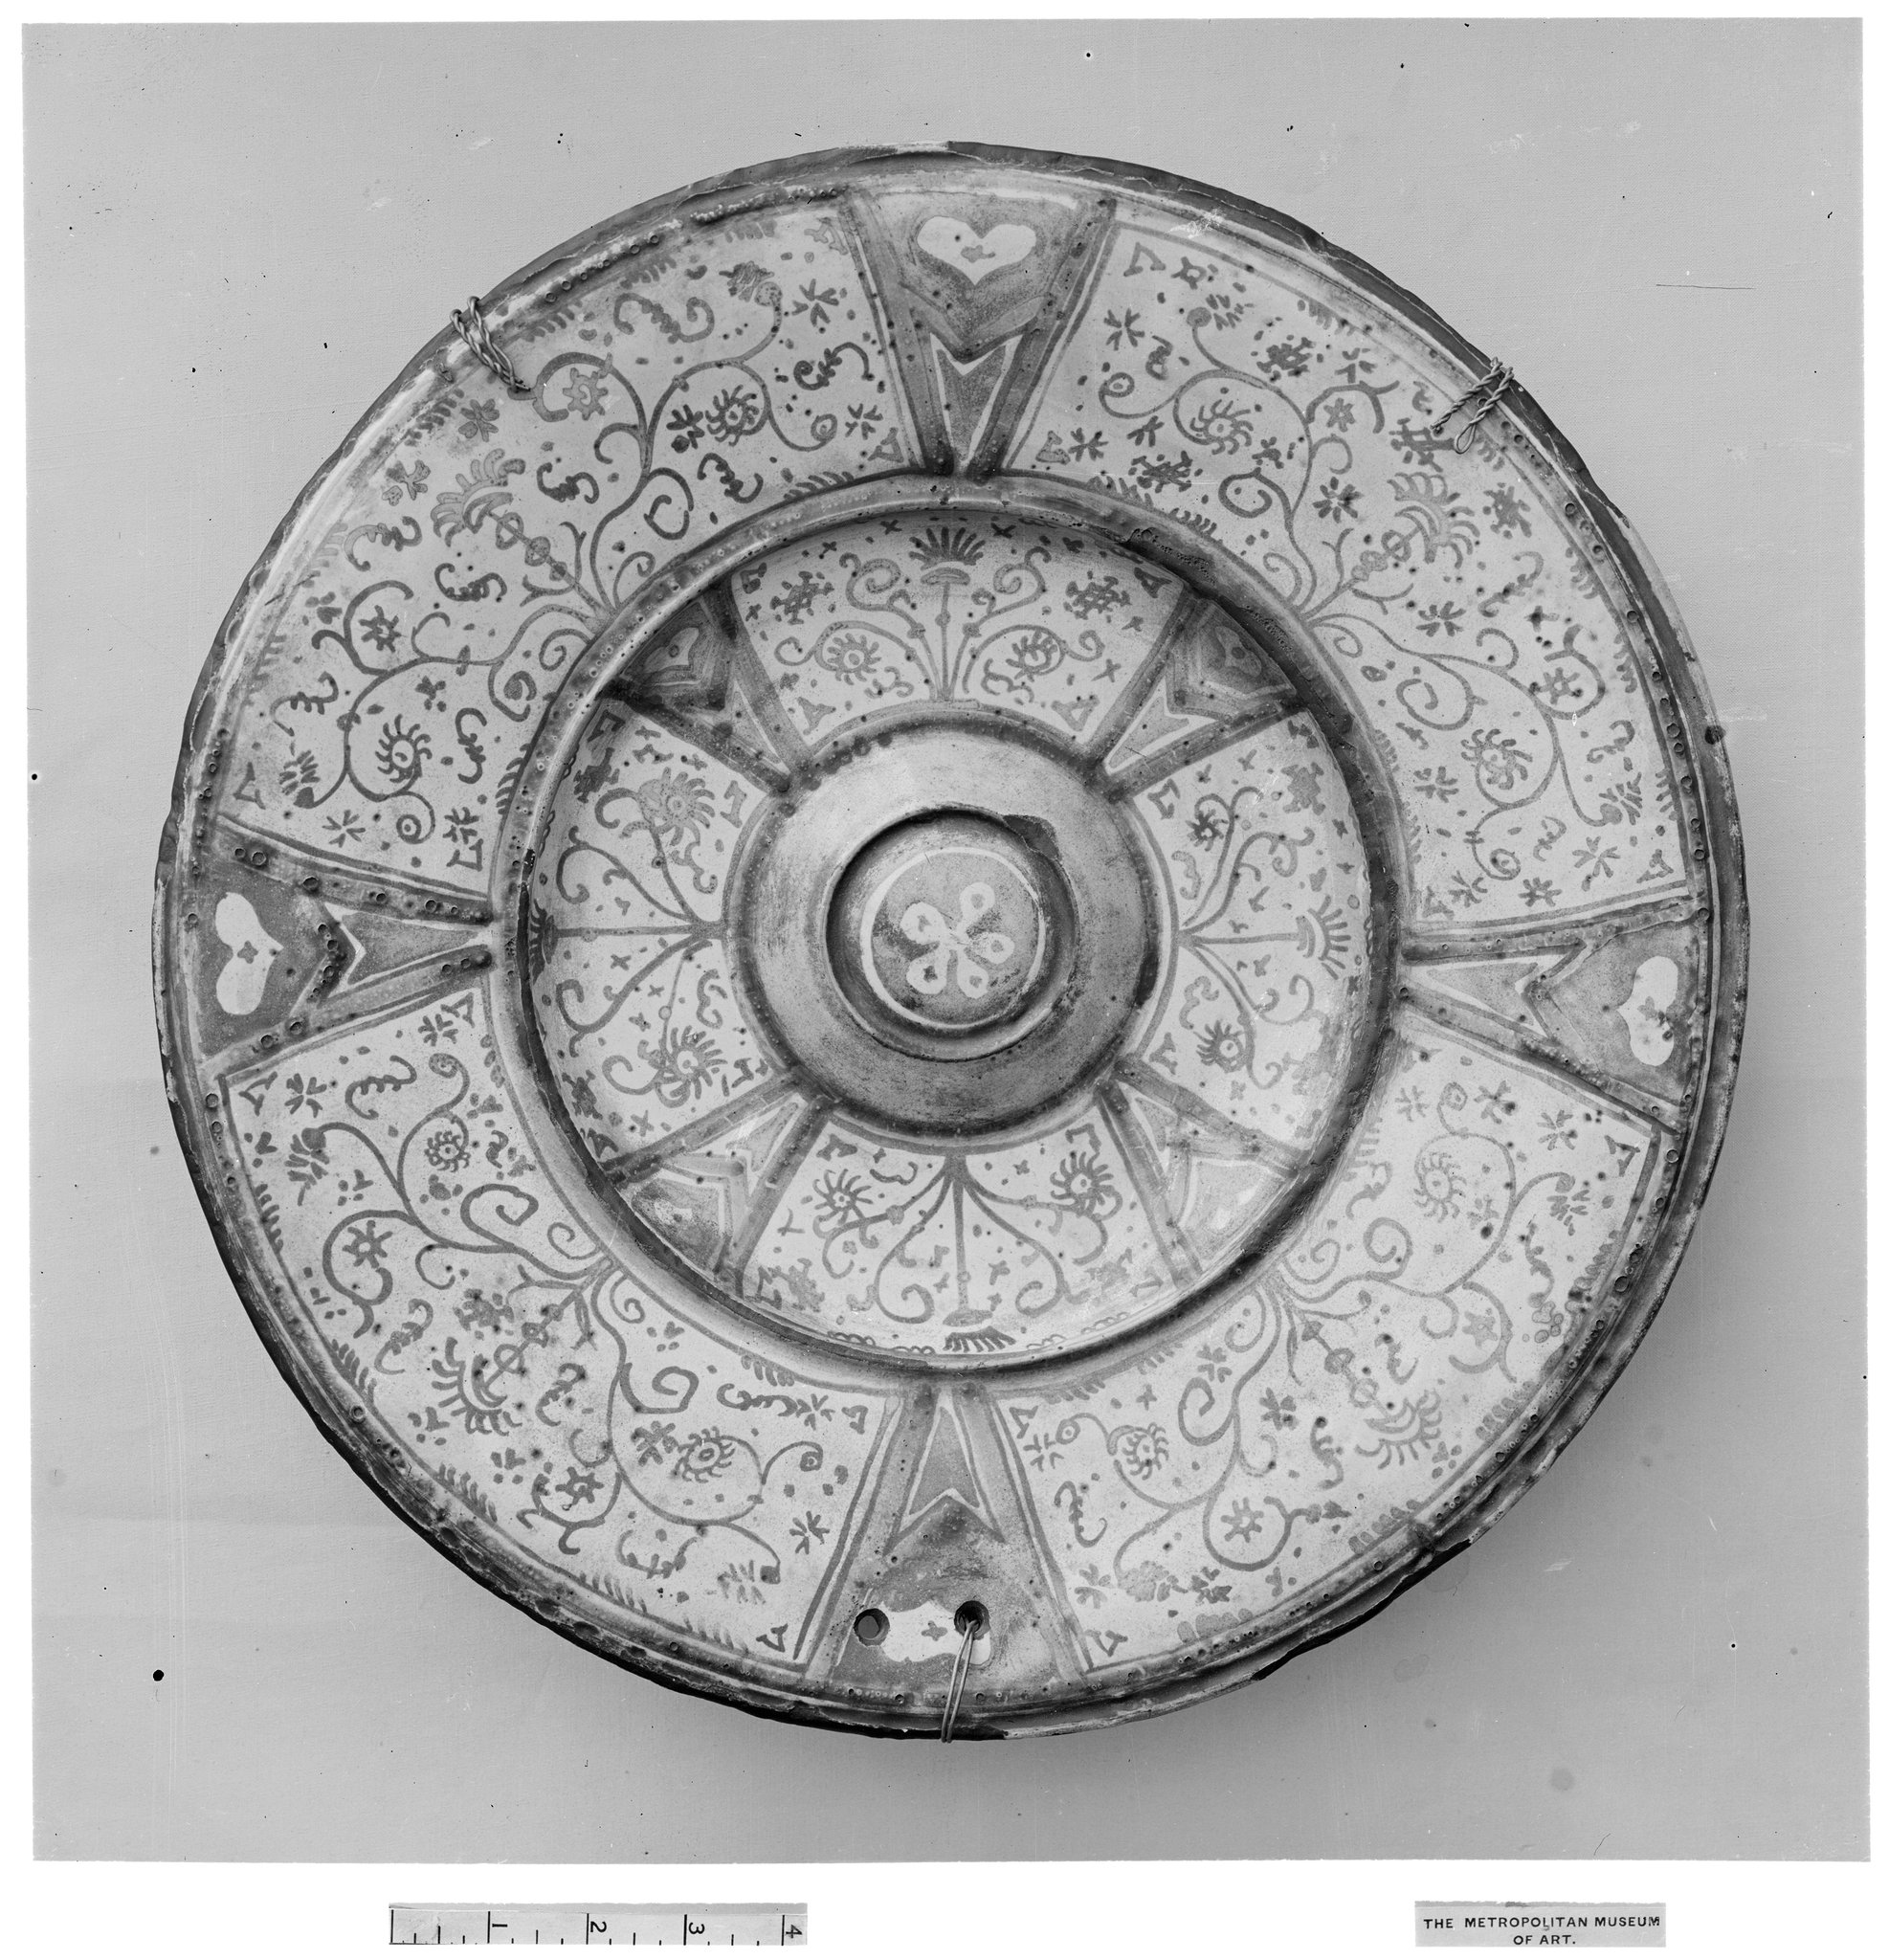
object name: dish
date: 1701-1800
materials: earthenware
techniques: luster painting, glazing